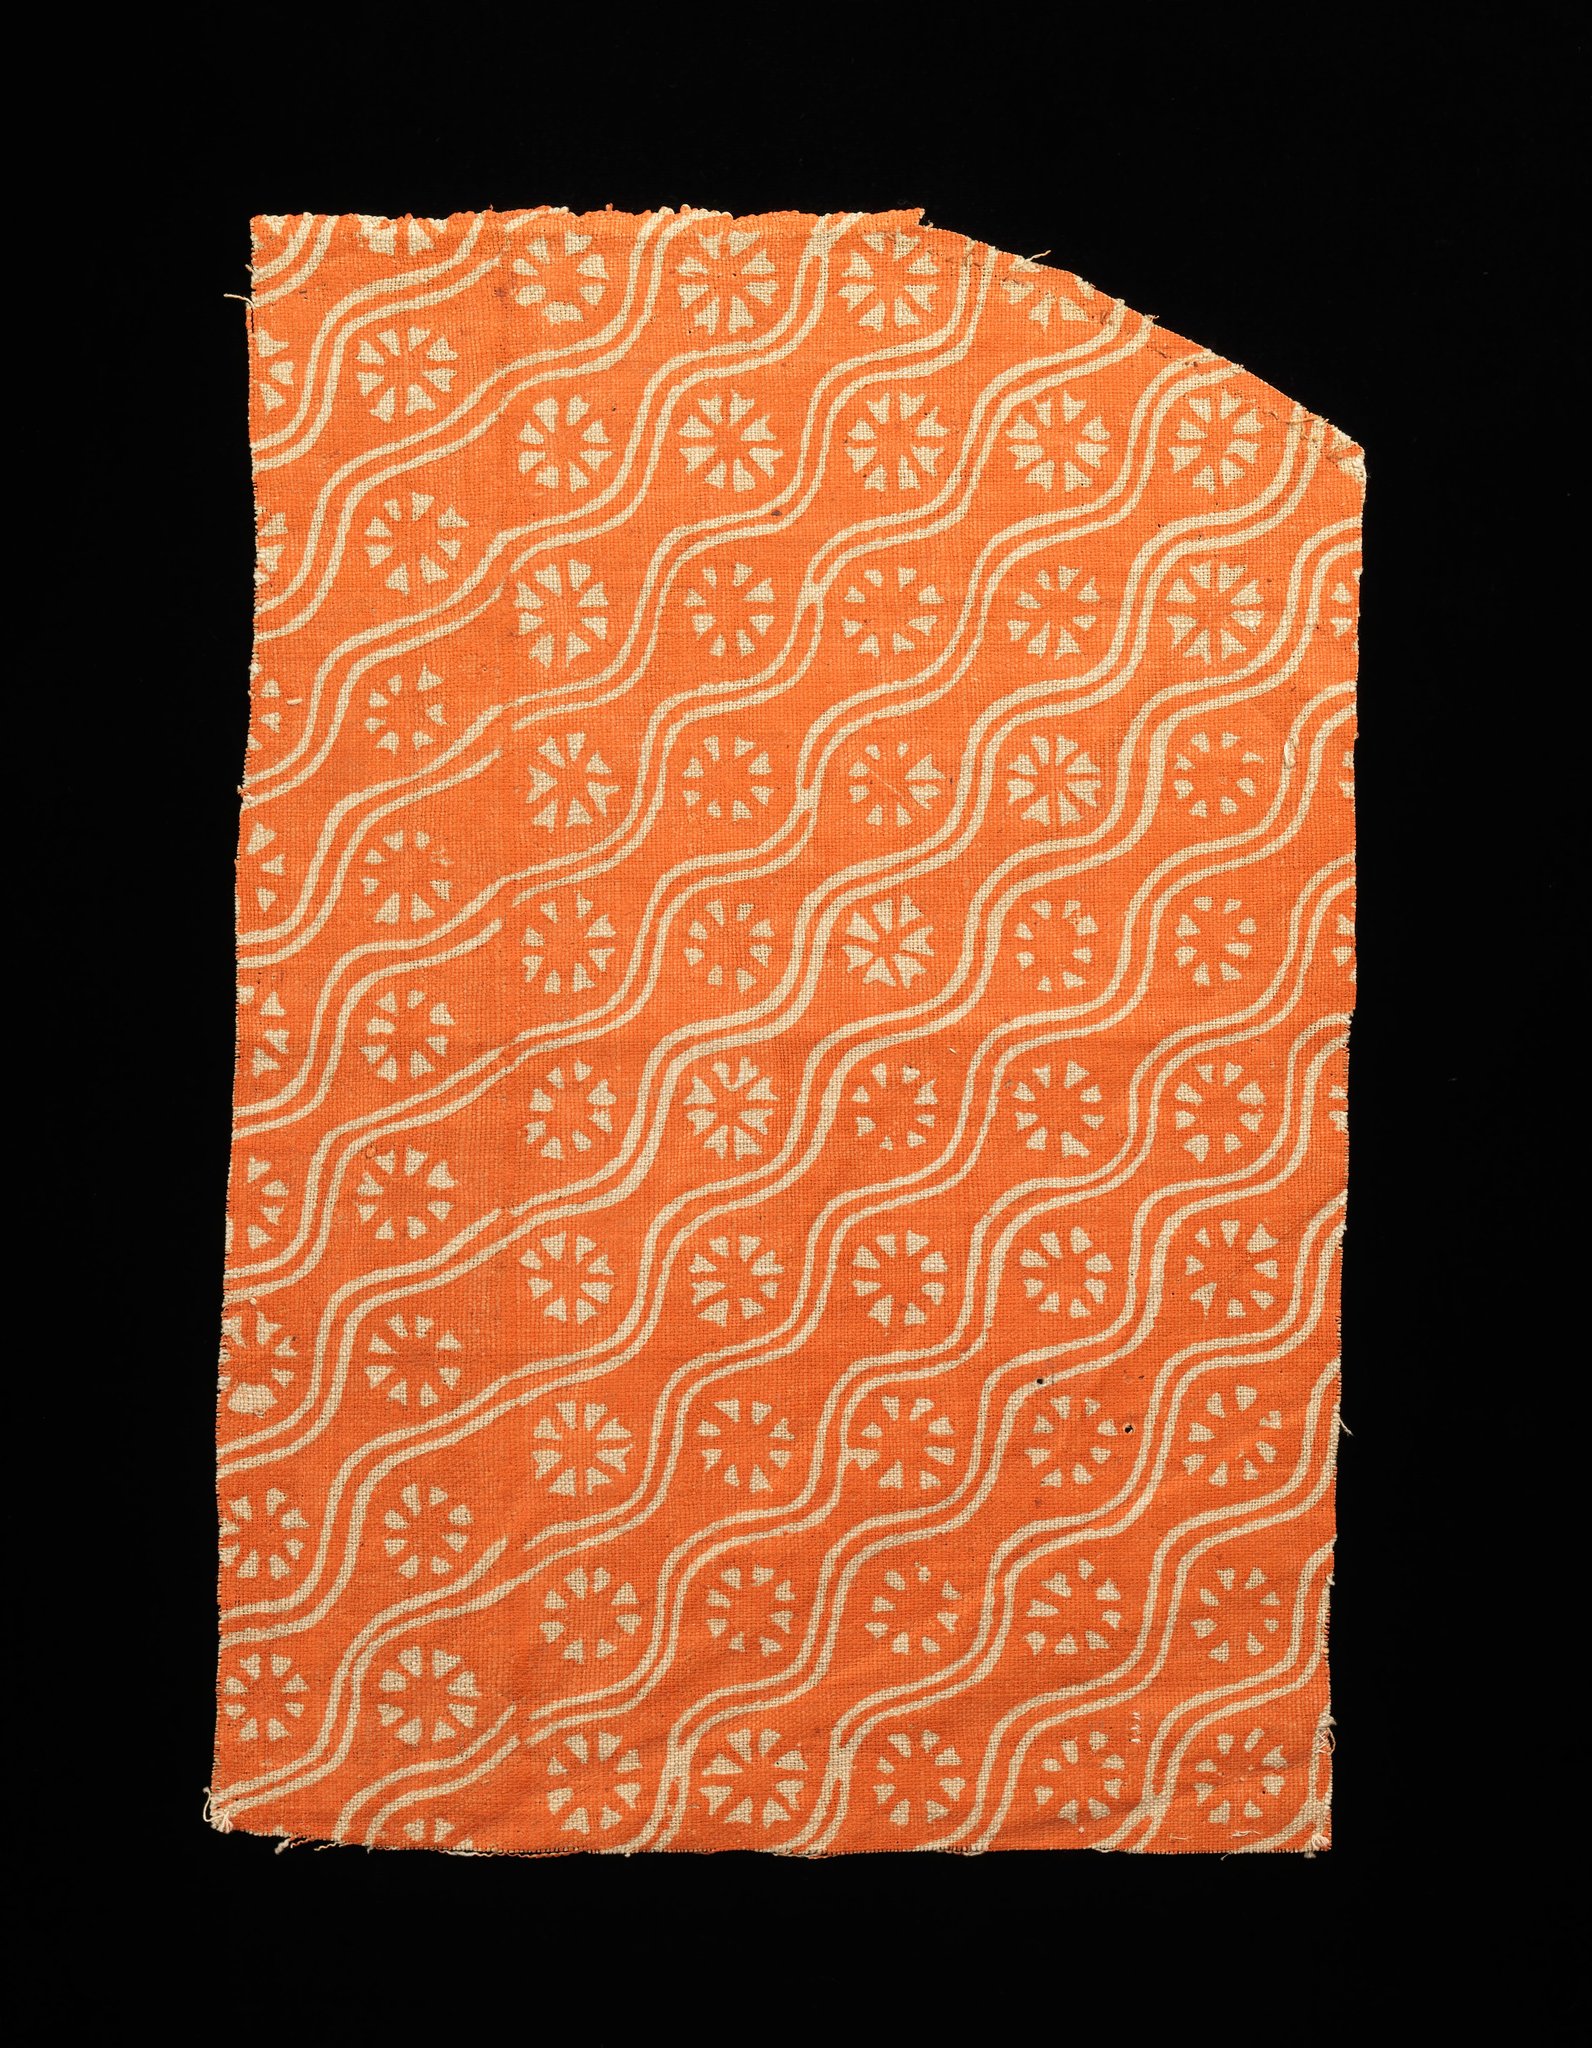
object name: textile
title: Textile fragment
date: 1700-1899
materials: linen